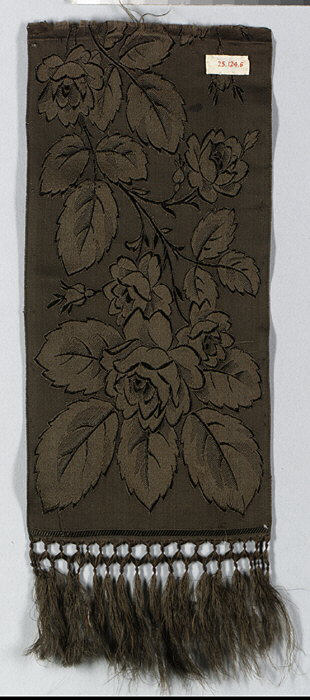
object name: necktie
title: Woman's necktie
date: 1870-1880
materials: silk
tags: roses